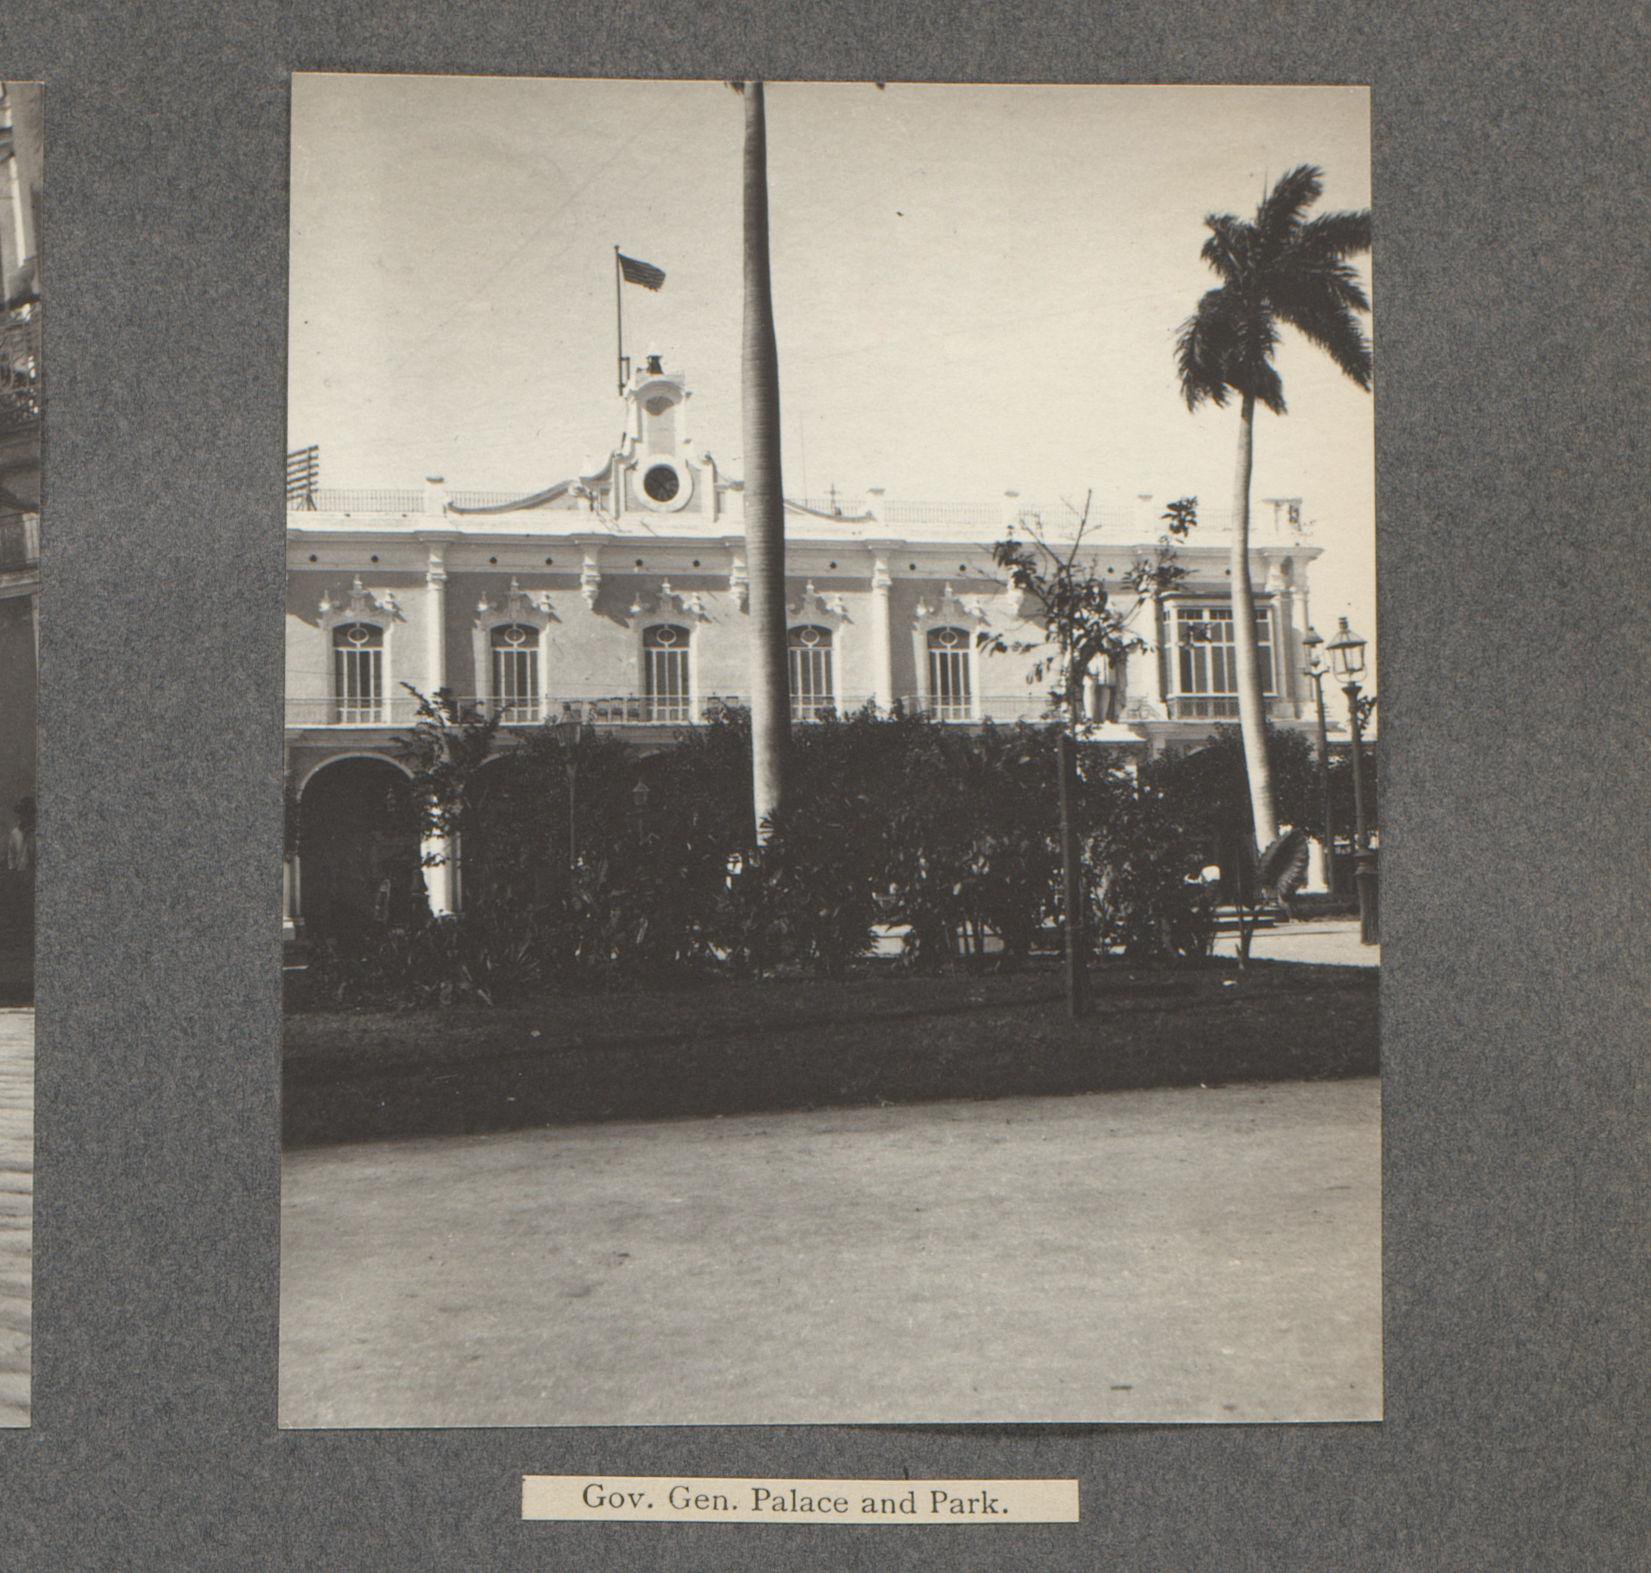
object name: album leaf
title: Gov. Gen. Palace and Park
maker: Anonymous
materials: paper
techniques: platinum process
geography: havana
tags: palace, exterior ~ representation of a building